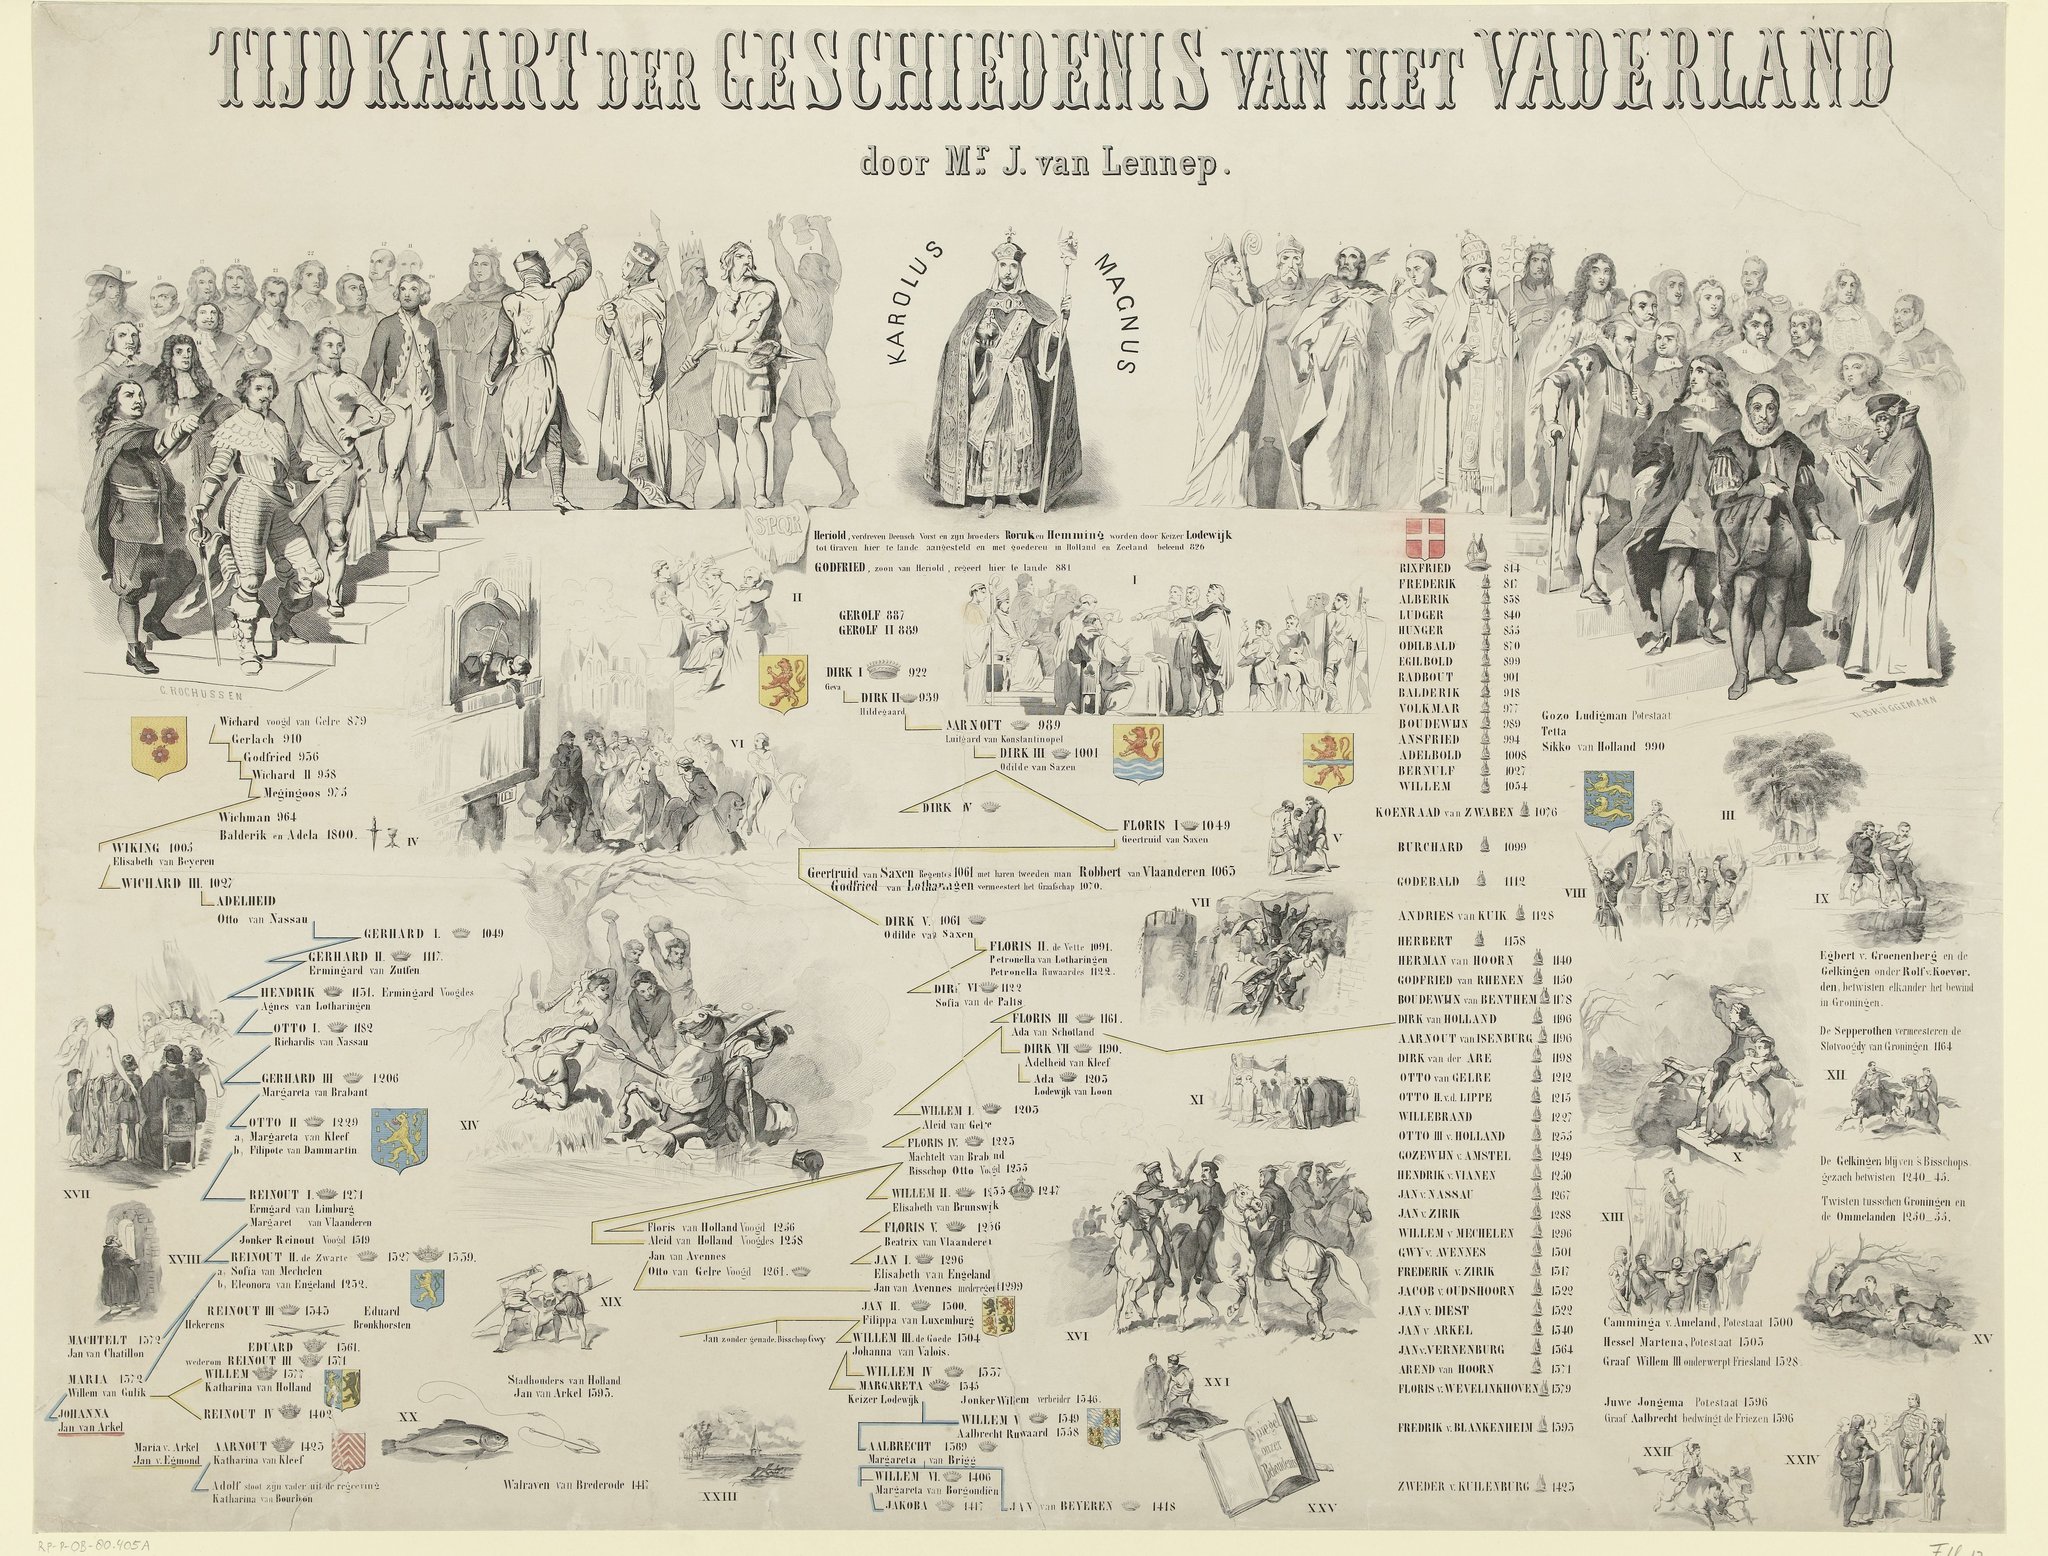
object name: print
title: Tijdkaart der Geschiedenis van het Vaderland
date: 1850-1855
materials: paper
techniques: hand coloring, lithograph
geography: haarlem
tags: statistic diagram, graph; pictorial chart, etc., netherlands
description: Tijdkaart der Geschiedenis van het Vaderland in twee delen waarvan dit de bovenste helft is. Overzicht van belangrijke jaartallen en gebeurtenissen in de geschiedenis van Nederland, krijgshelden, dichters en geleerden, staatslieden en volksverlichters en kunstbeoefenaars. Vanaf Karel de Grote tot aan koning Willem III. Met gekleurde wapens en banieren.